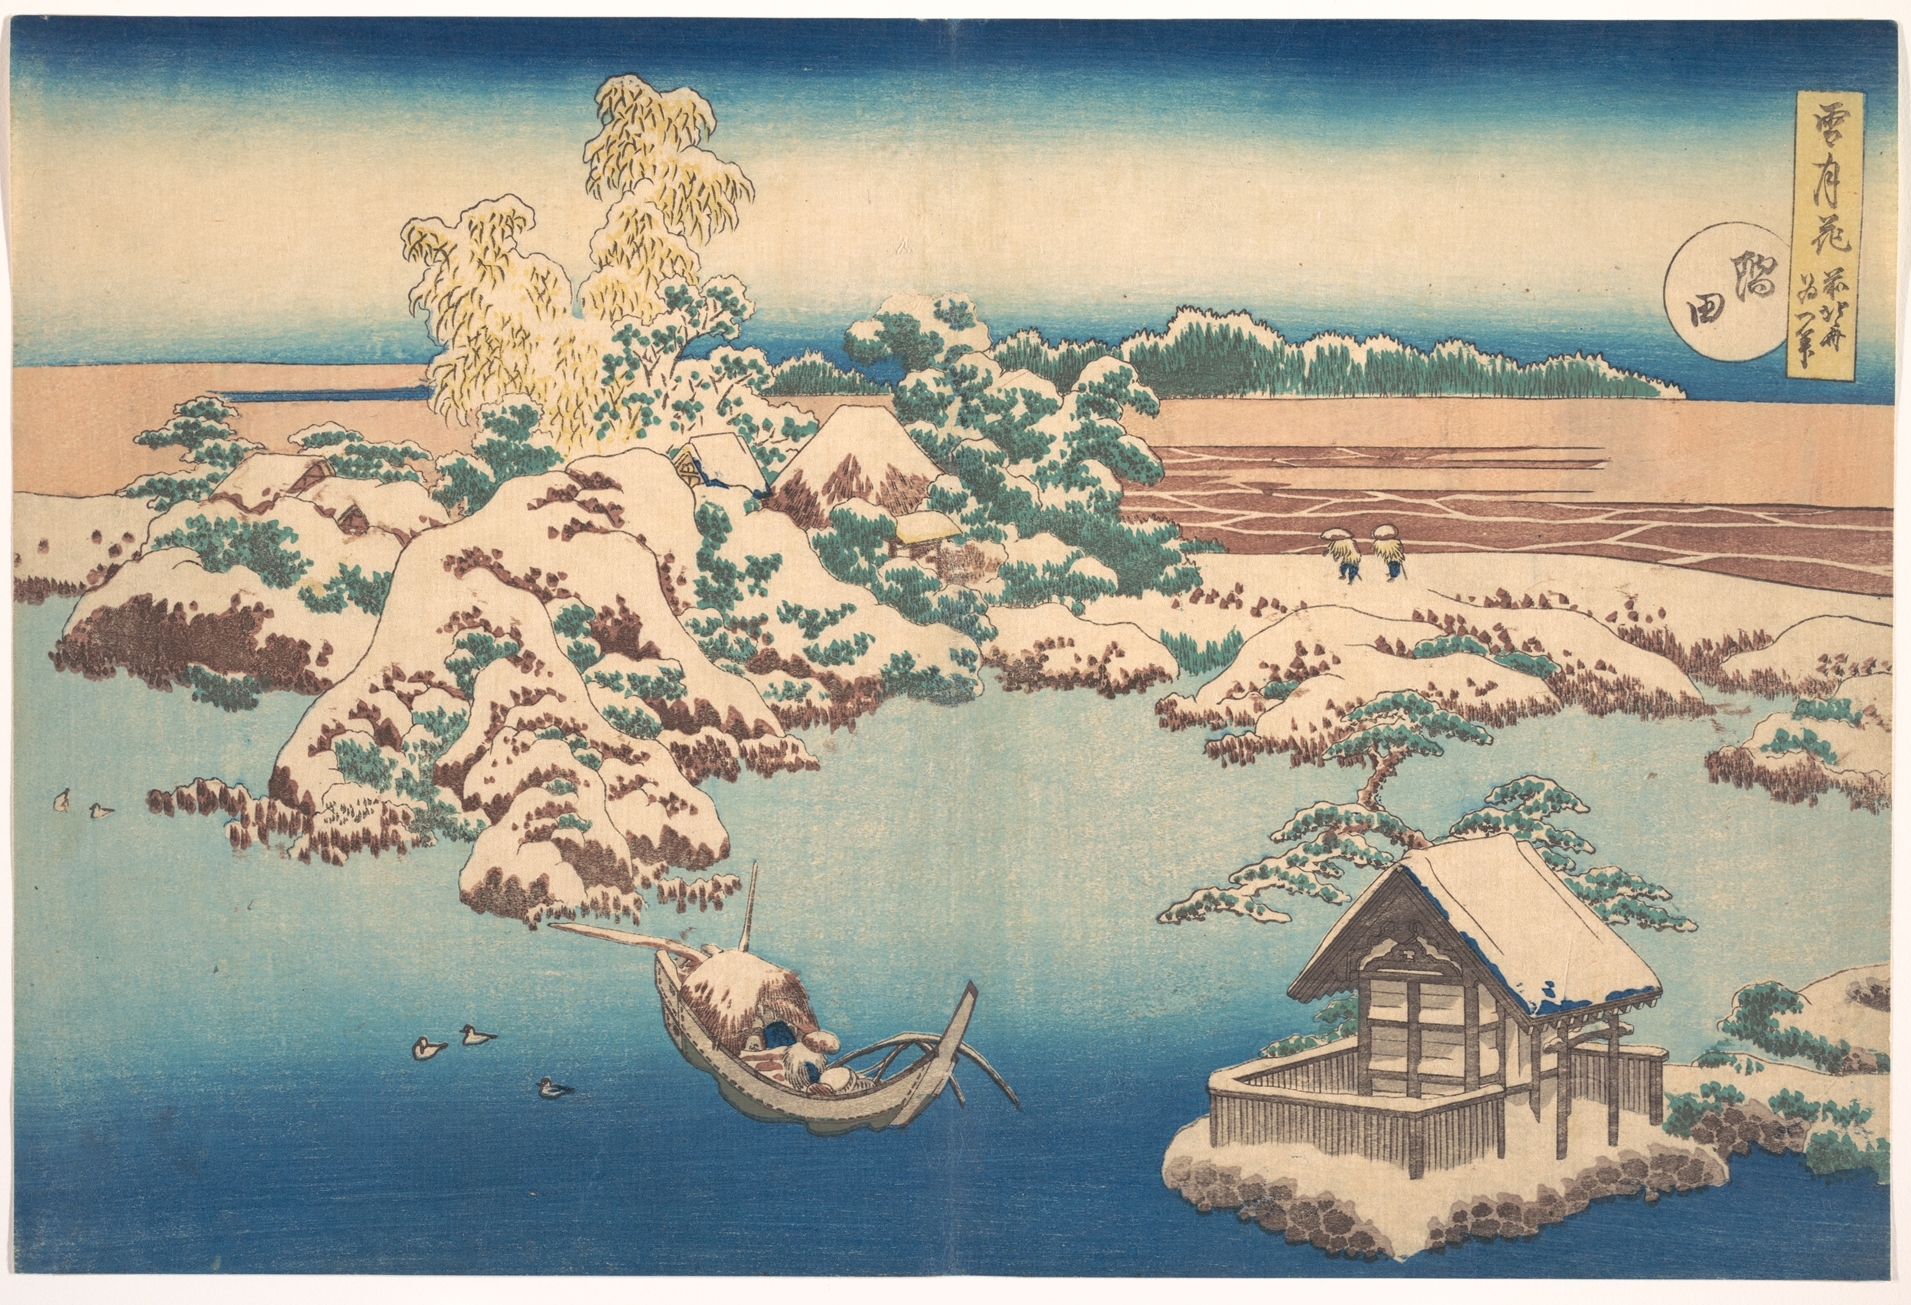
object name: woodblock print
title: Snow on the Sumida River (Sumida), from the series, Snow, Moon, and Flowers (Setsugekka)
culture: japanese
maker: katsushika hokusai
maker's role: artist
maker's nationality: japanese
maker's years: 1760-1849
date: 1833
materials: ink, paper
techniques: woodblock print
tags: rivers,landscapes,snow,boats